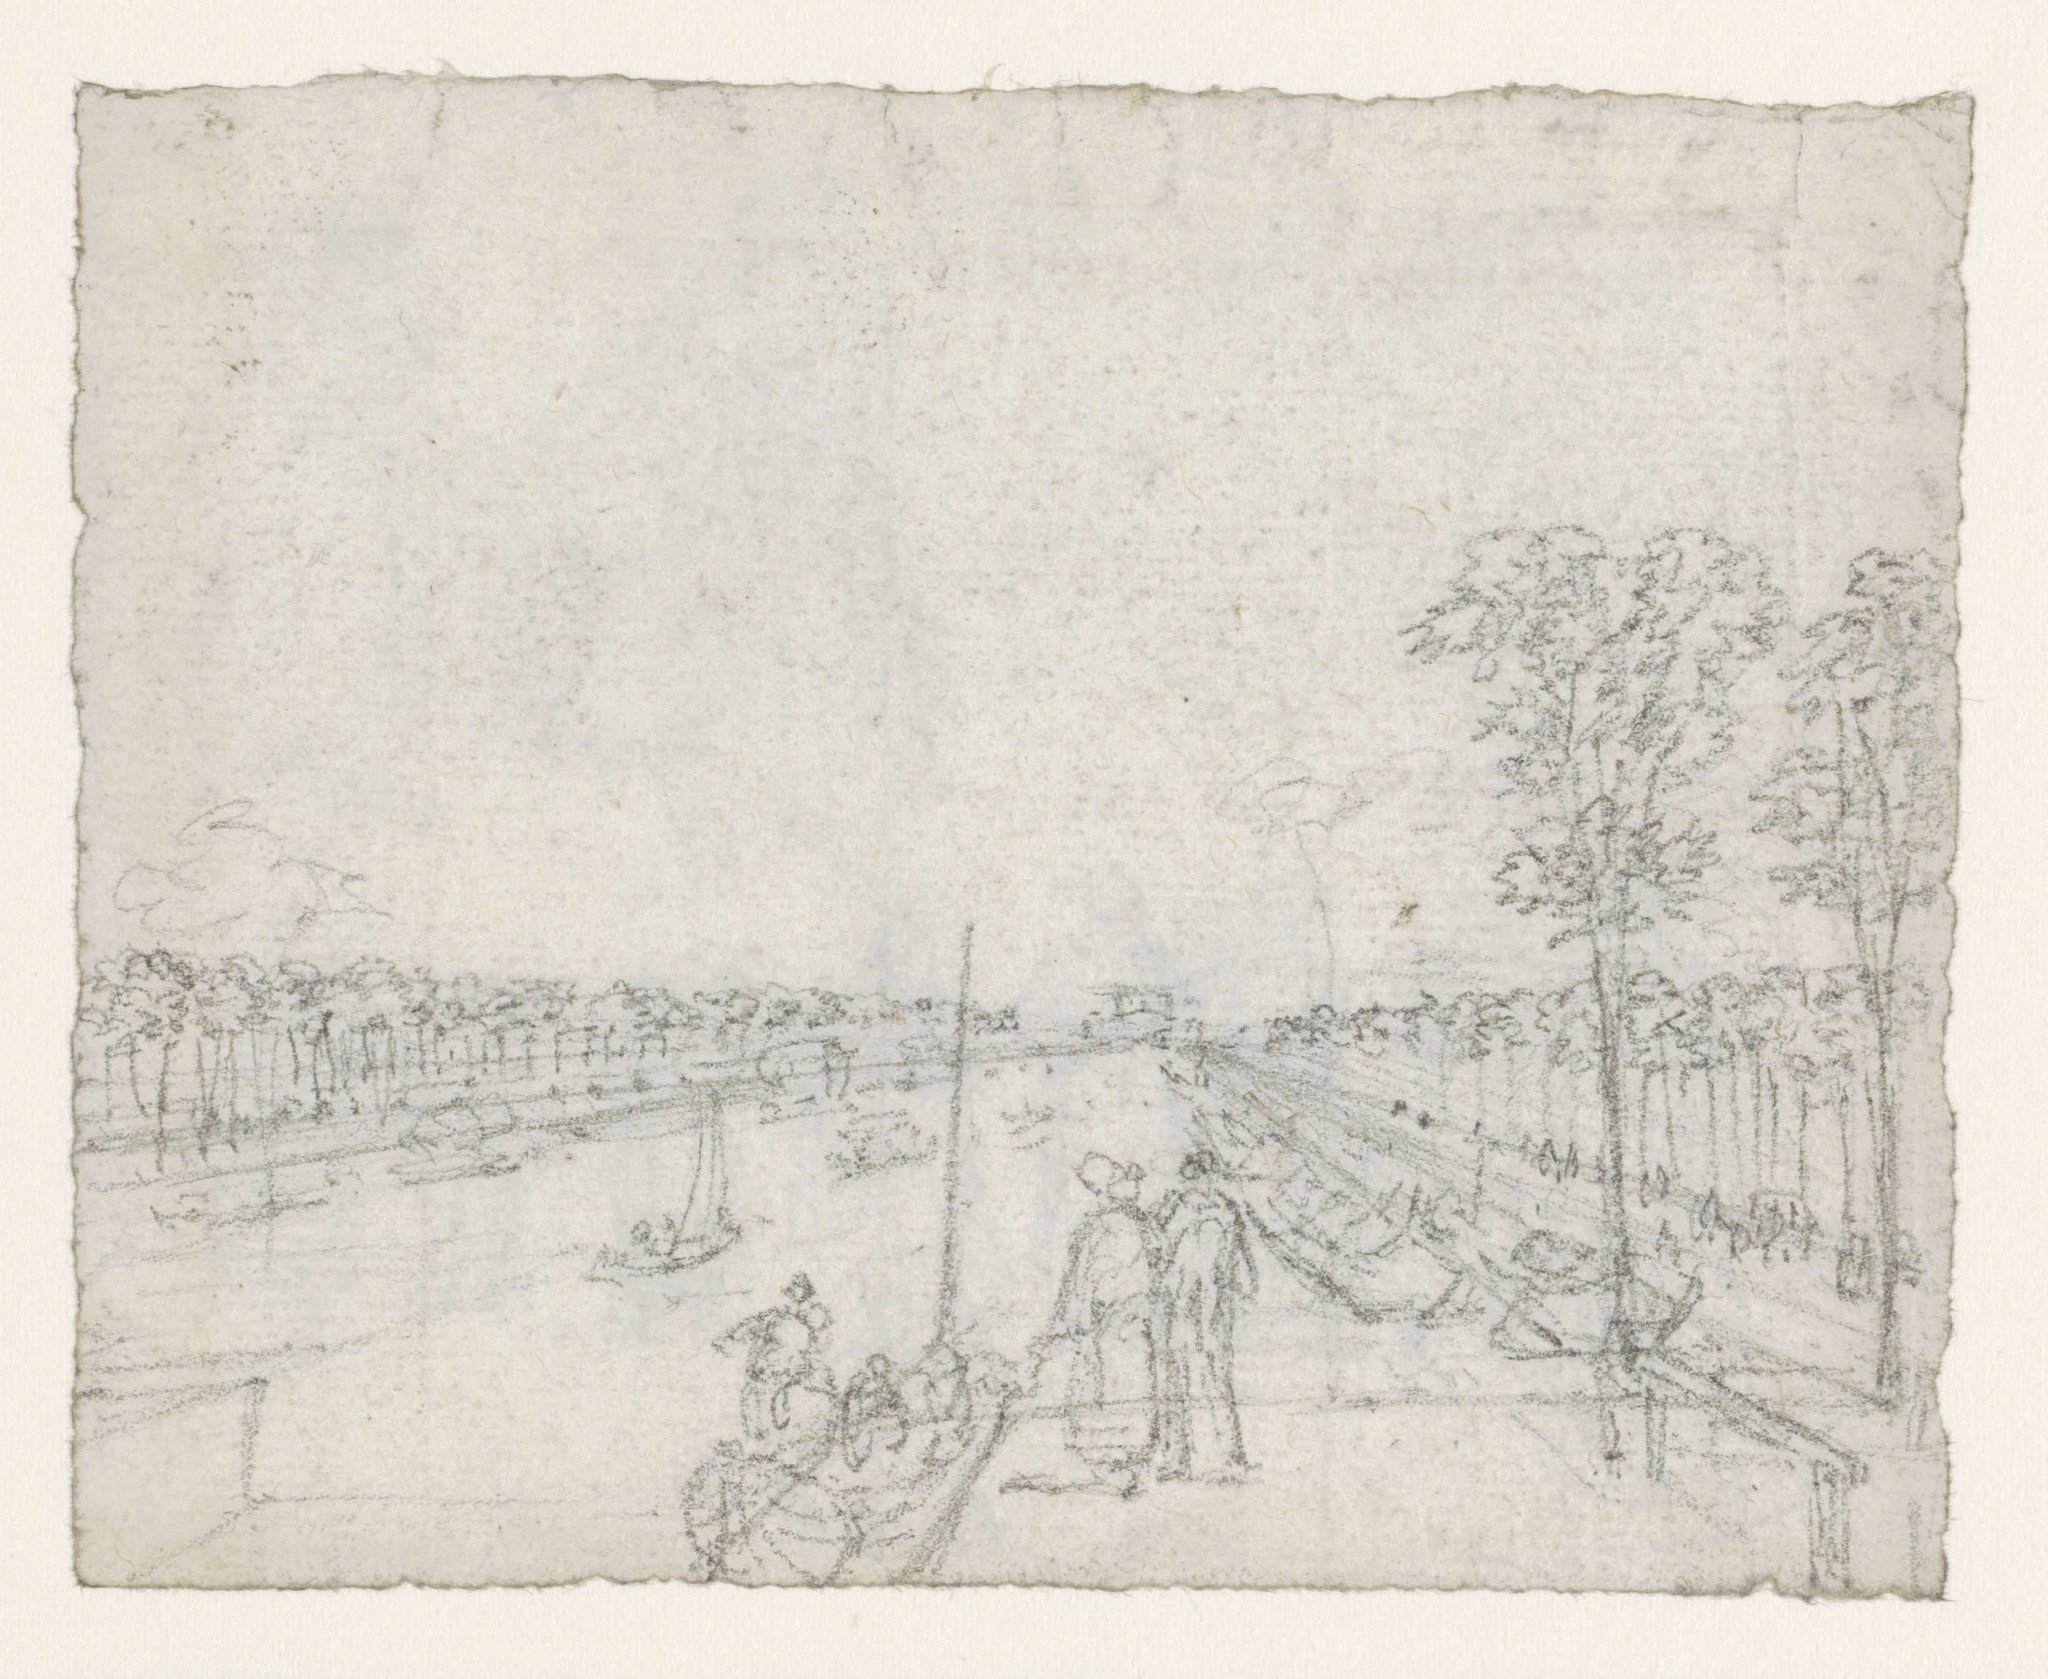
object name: drawing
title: Canal St. Martin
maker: georges michel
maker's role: draughtsman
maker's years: 1763-1843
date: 1773-1843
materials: paper, pencil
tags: canals, waters (in city) (+ city(-scape) with figures, staffage)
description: Een van 120 tekeningen, afkomstig uit een 19e eeuws album met tekeningen van Georges Michel.